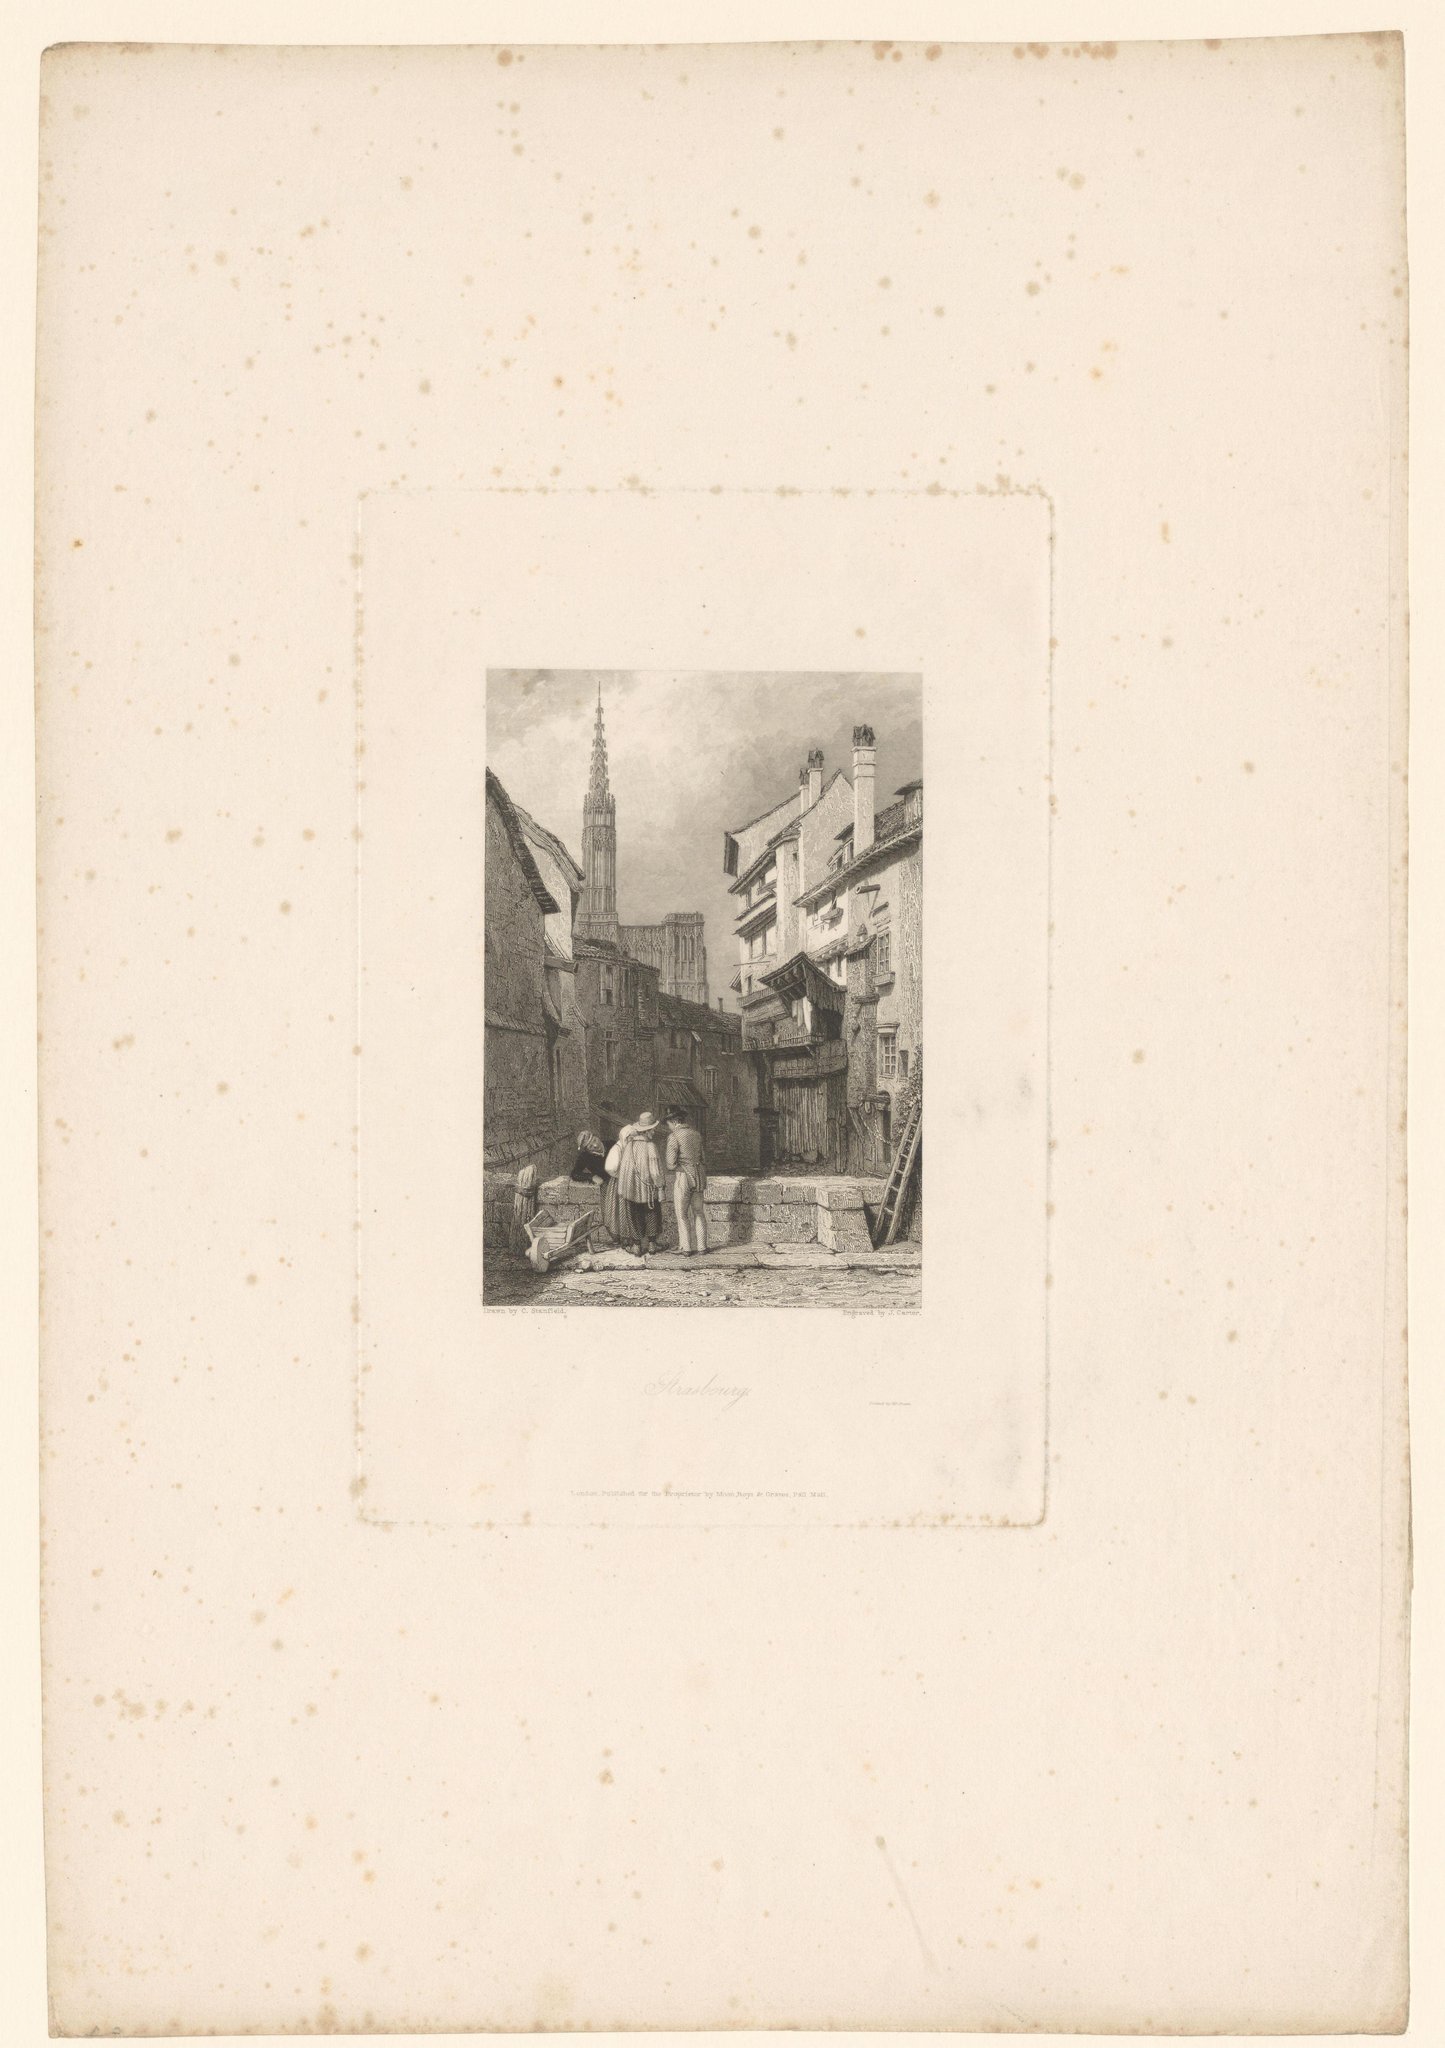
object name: print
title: Gezicht op de toren van de kathedraal van Straatsburg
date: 1827-1836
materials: paper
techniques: engraving, etching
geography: london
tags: city-view in general; 'veduta', roman catholic church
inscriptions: collector's mark: Lugt 2228